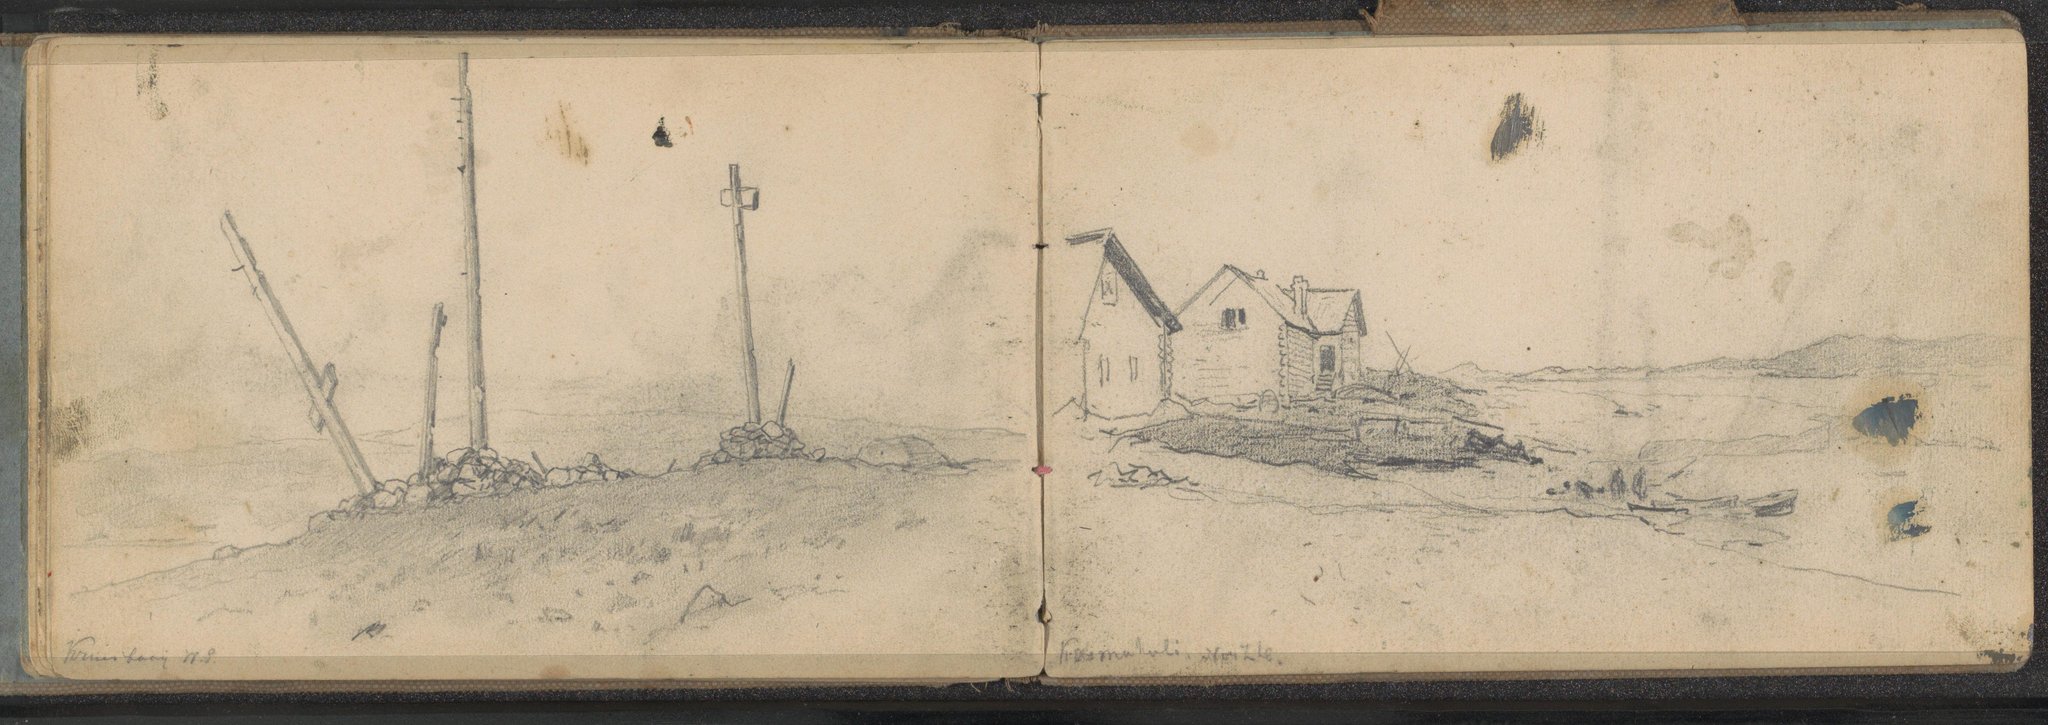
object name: sketchbook leaf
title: Gezicht op het Russische station te Malye Karmakuli, Nova Zembla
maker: louis apol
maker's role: draughtsman, painter, print maker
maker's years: 1850-1936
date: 1880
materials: paper, pencil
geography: malye karmakuly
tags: coast (in polar regions) (+ landscape (in the non-temperate zone) with figures, staffage), hut, cabin, lodge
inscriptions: annotation: ‘Karmakuli, Nov. Zla.’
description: Blad 32 recto uit een schetsboek met 35 bladen betekend tijdens de expeditie naar Nova Zembla in 1880.